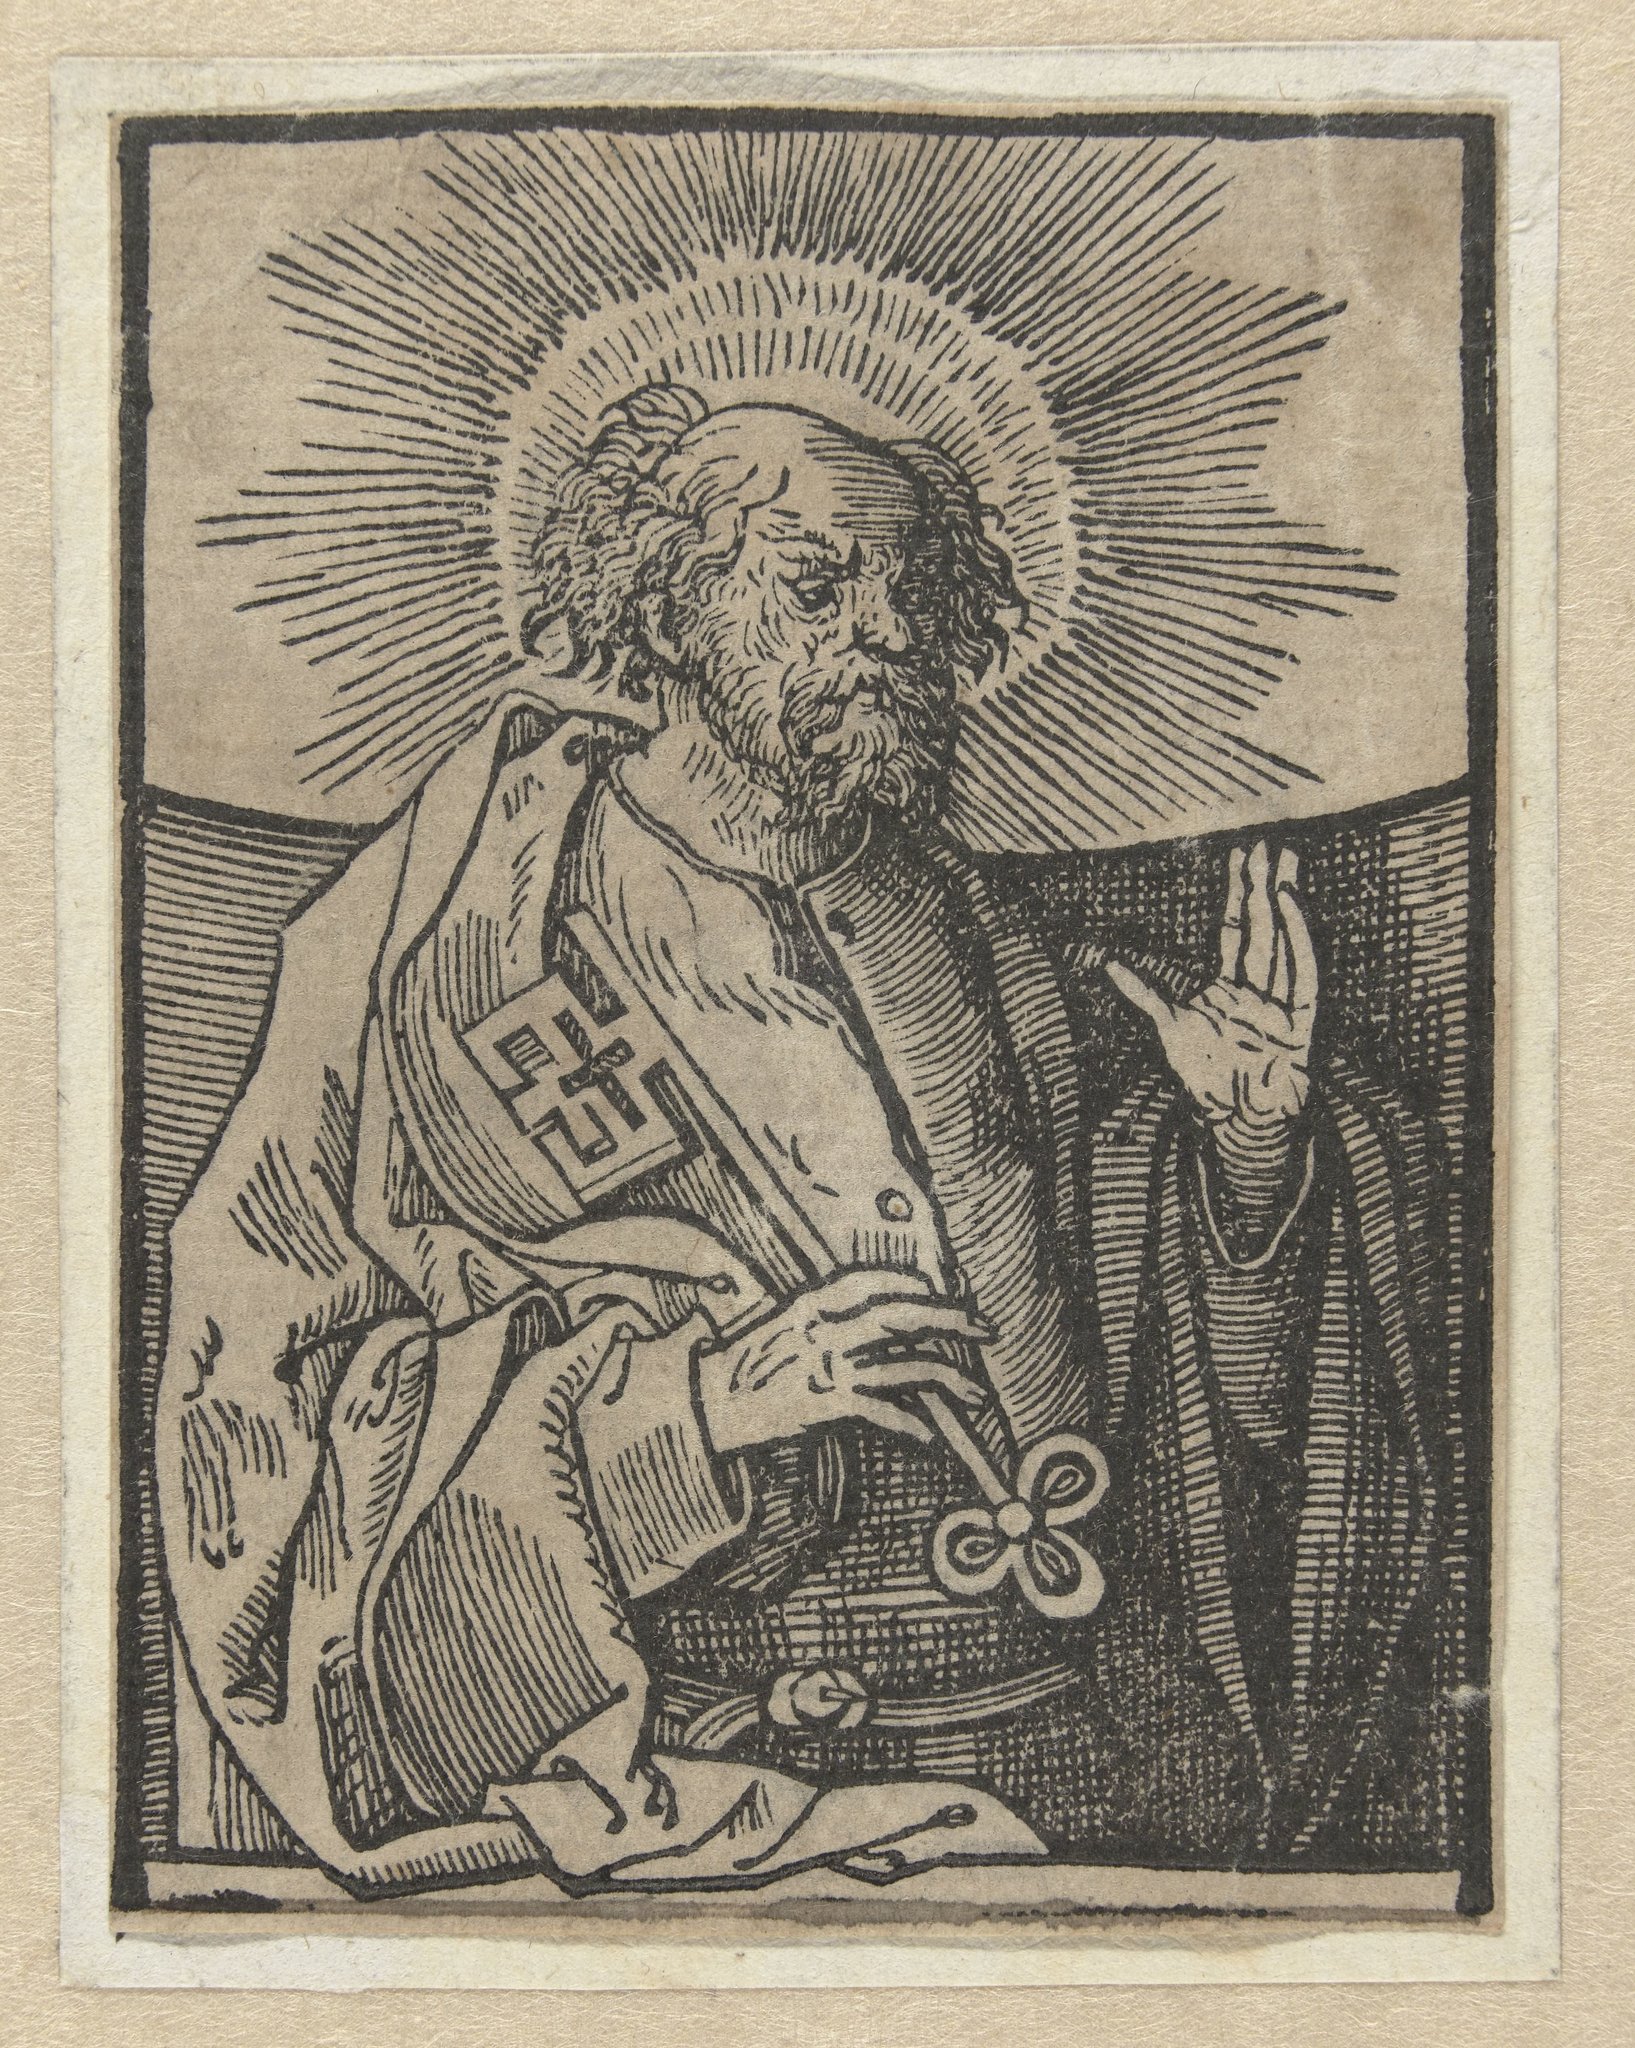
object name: print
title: De apostel Petrus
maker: Anonymous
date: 1518-1550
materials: paper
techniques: woodcut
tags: the apostle peter, first bishop of rome; possible attributes: book, cock, (upturned) cross, (triple) crozier, fish, key, scroll, ship, tiara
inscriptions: collector's mark: Lugt 240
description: Eén van serie van acht originelen en vier in kopie bewaarde houtsneden.